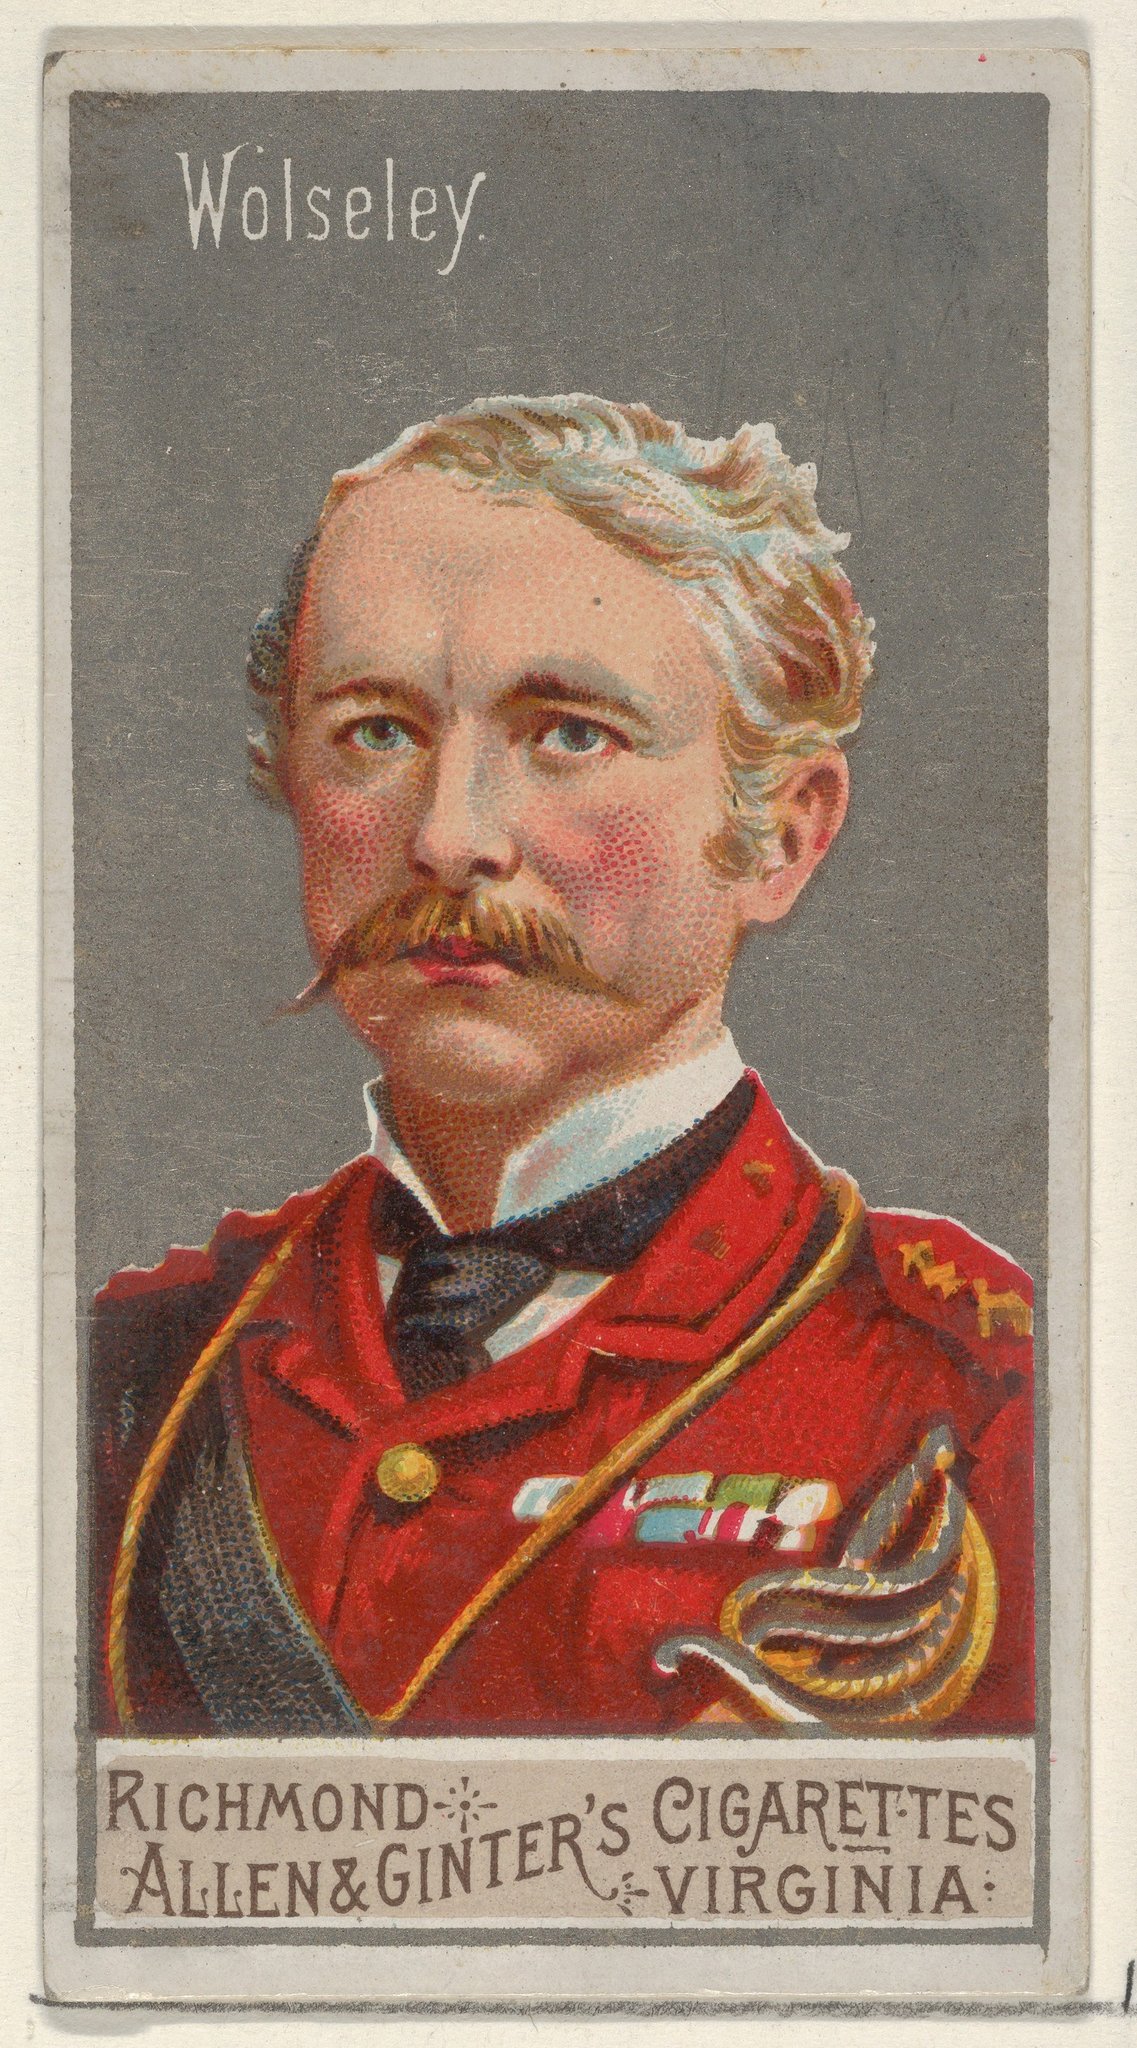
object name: print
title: Garnet Joseph Wolseley, from the Great Generals series (N15) for Allen & Ginter Cigarettes Brands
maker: allen & ginter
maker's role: publisher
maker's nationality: american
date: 1888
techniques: color lithograph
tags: historical figures,men,generals